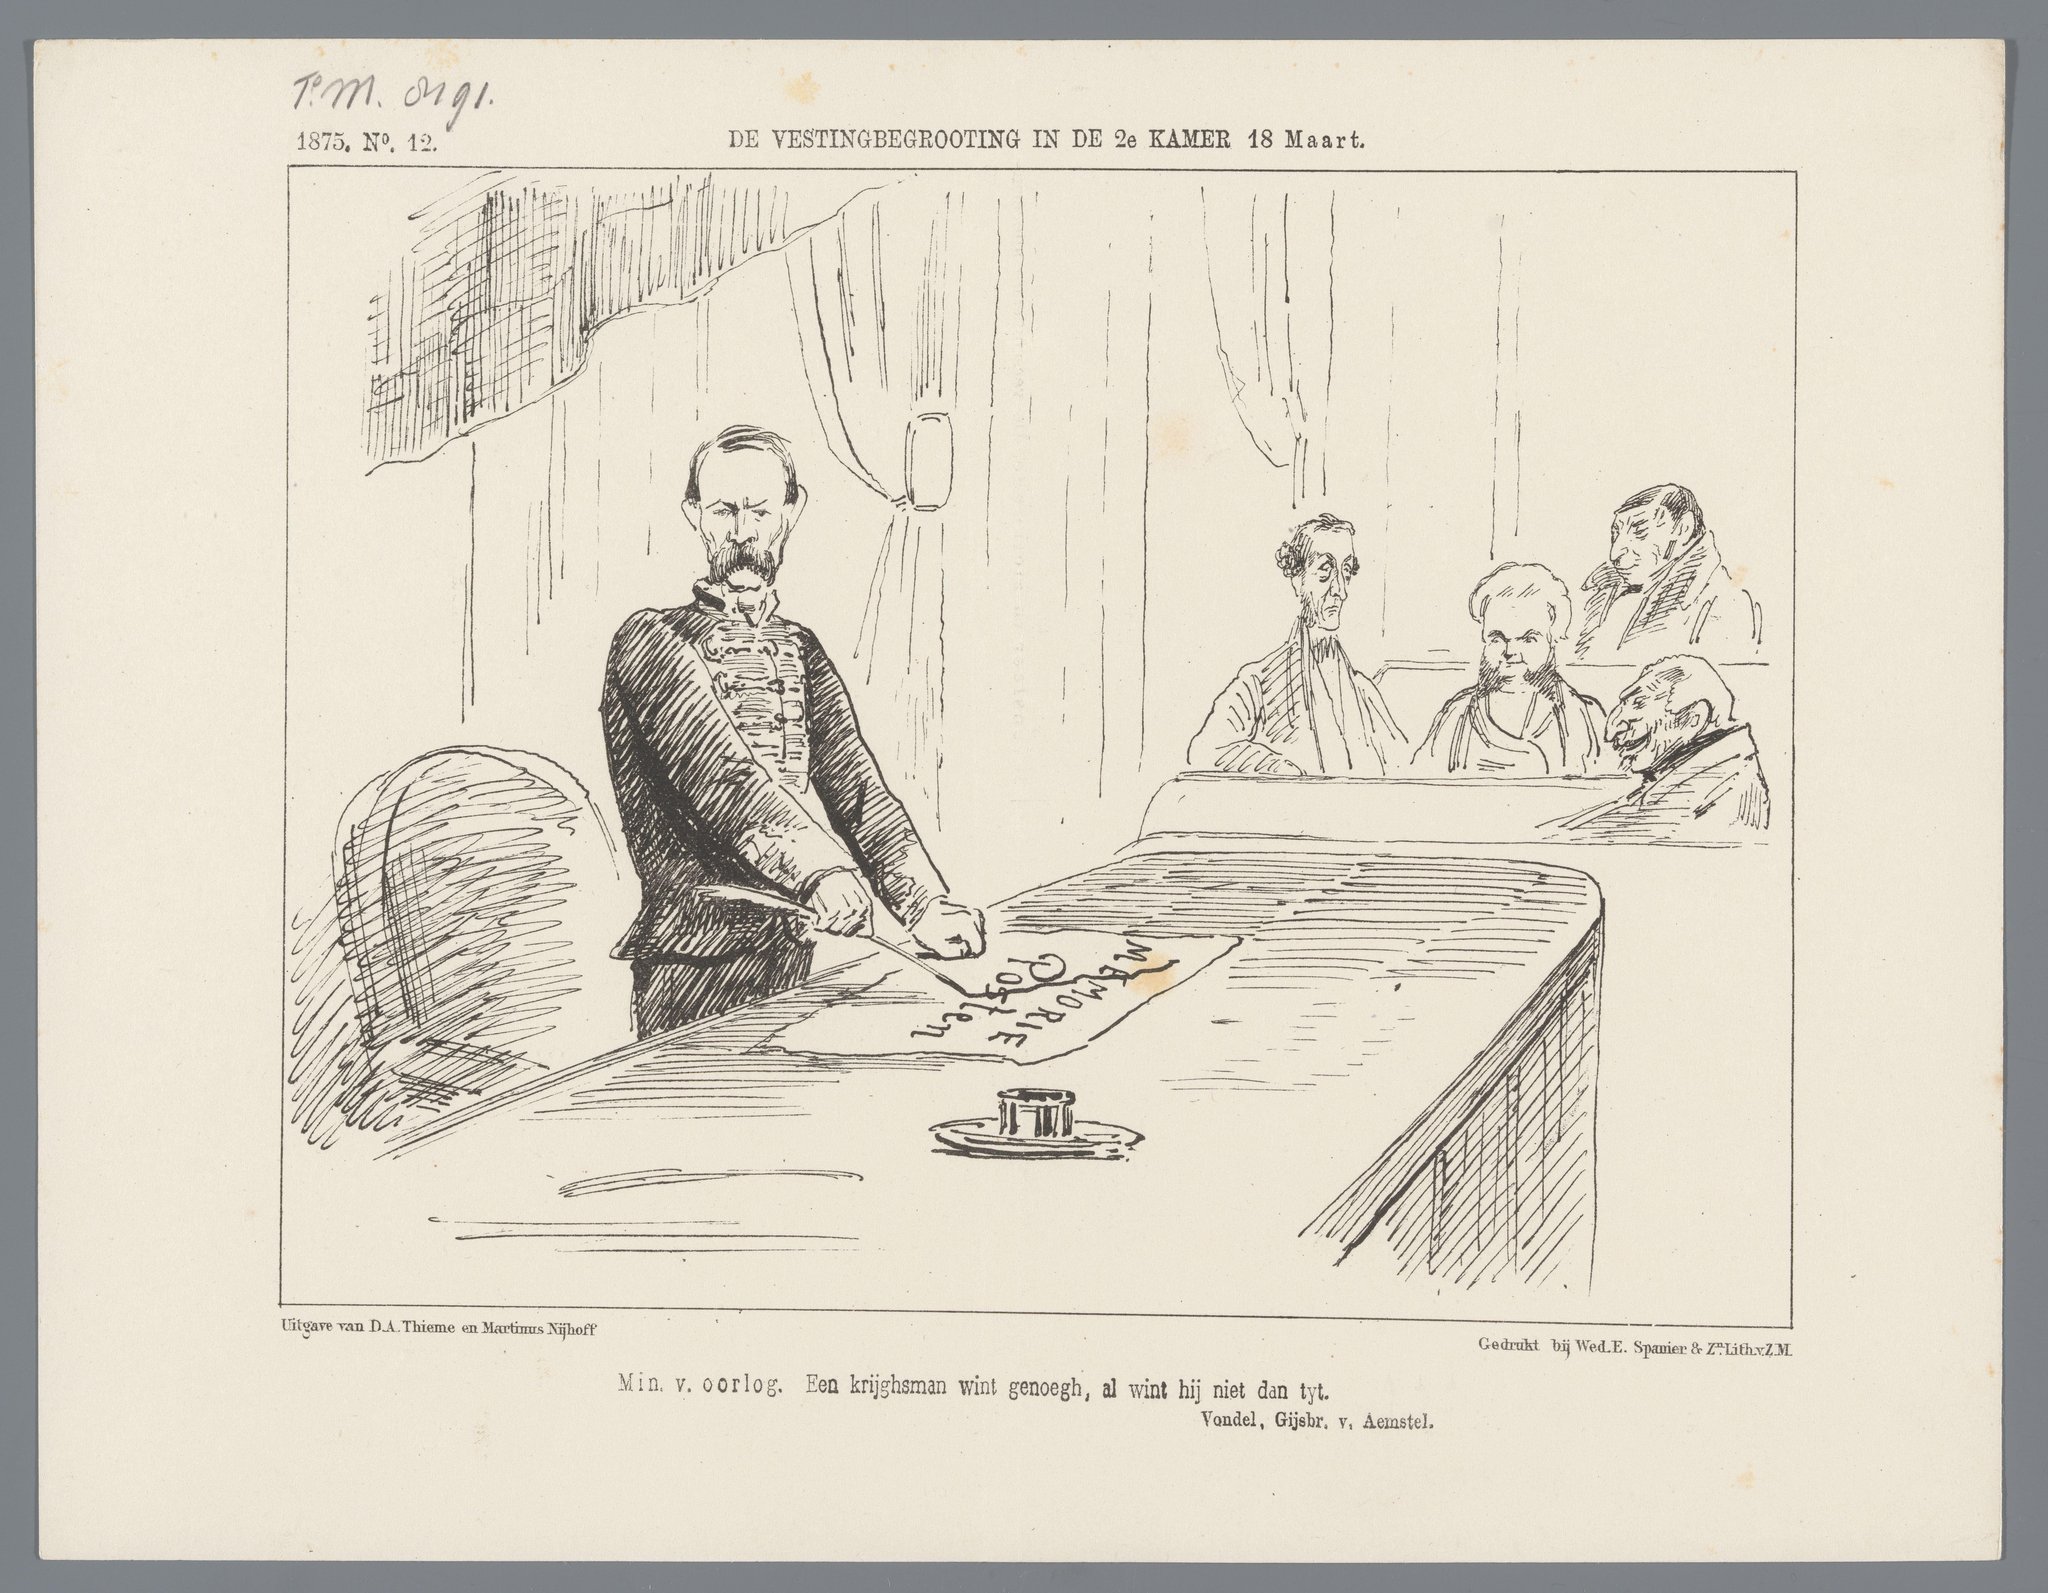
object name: print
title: Spotprent op het debat rond het vestingstelsel, 1875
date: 1875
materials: paper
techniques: lithograph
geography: the hague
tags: tweede kamer der staten-generaal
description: Spotprent op het debat in de Tweede Kamer rond de financiering van het nieuwe vestingstelsel, 1875 . Plaat verschenen bij het weekblad De Nederlandsche Spectator, nr. 12, 1875.